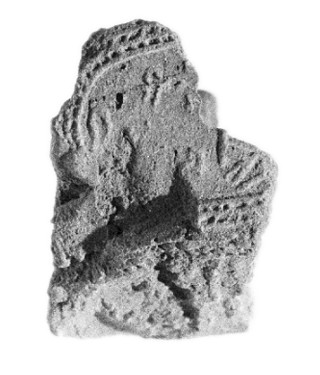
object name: sealing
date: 1981-1640 BCE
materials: mud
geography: egypt